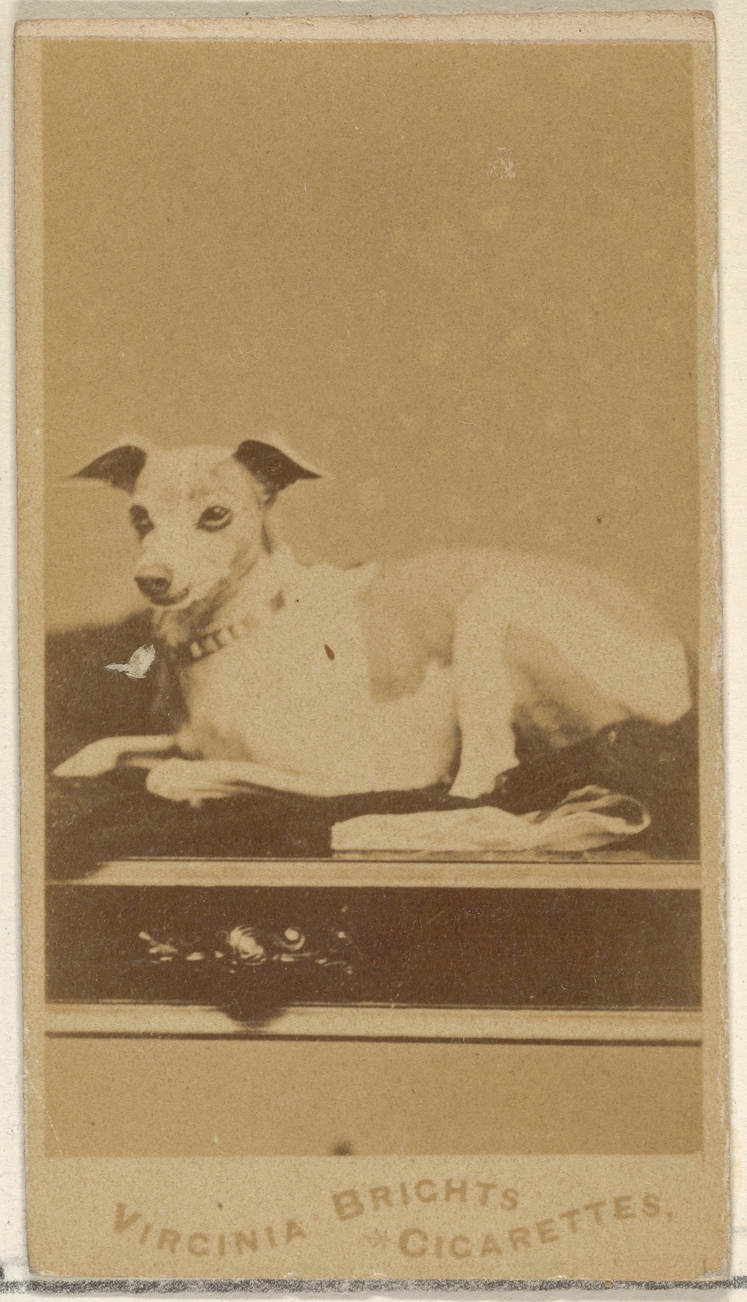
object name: photograph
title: From the Dogs series (N47) for Virginia Brights Cigarettes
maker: allen & ginter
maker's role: publisher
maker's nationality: american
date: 1888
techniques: albumen silver print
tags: dogs